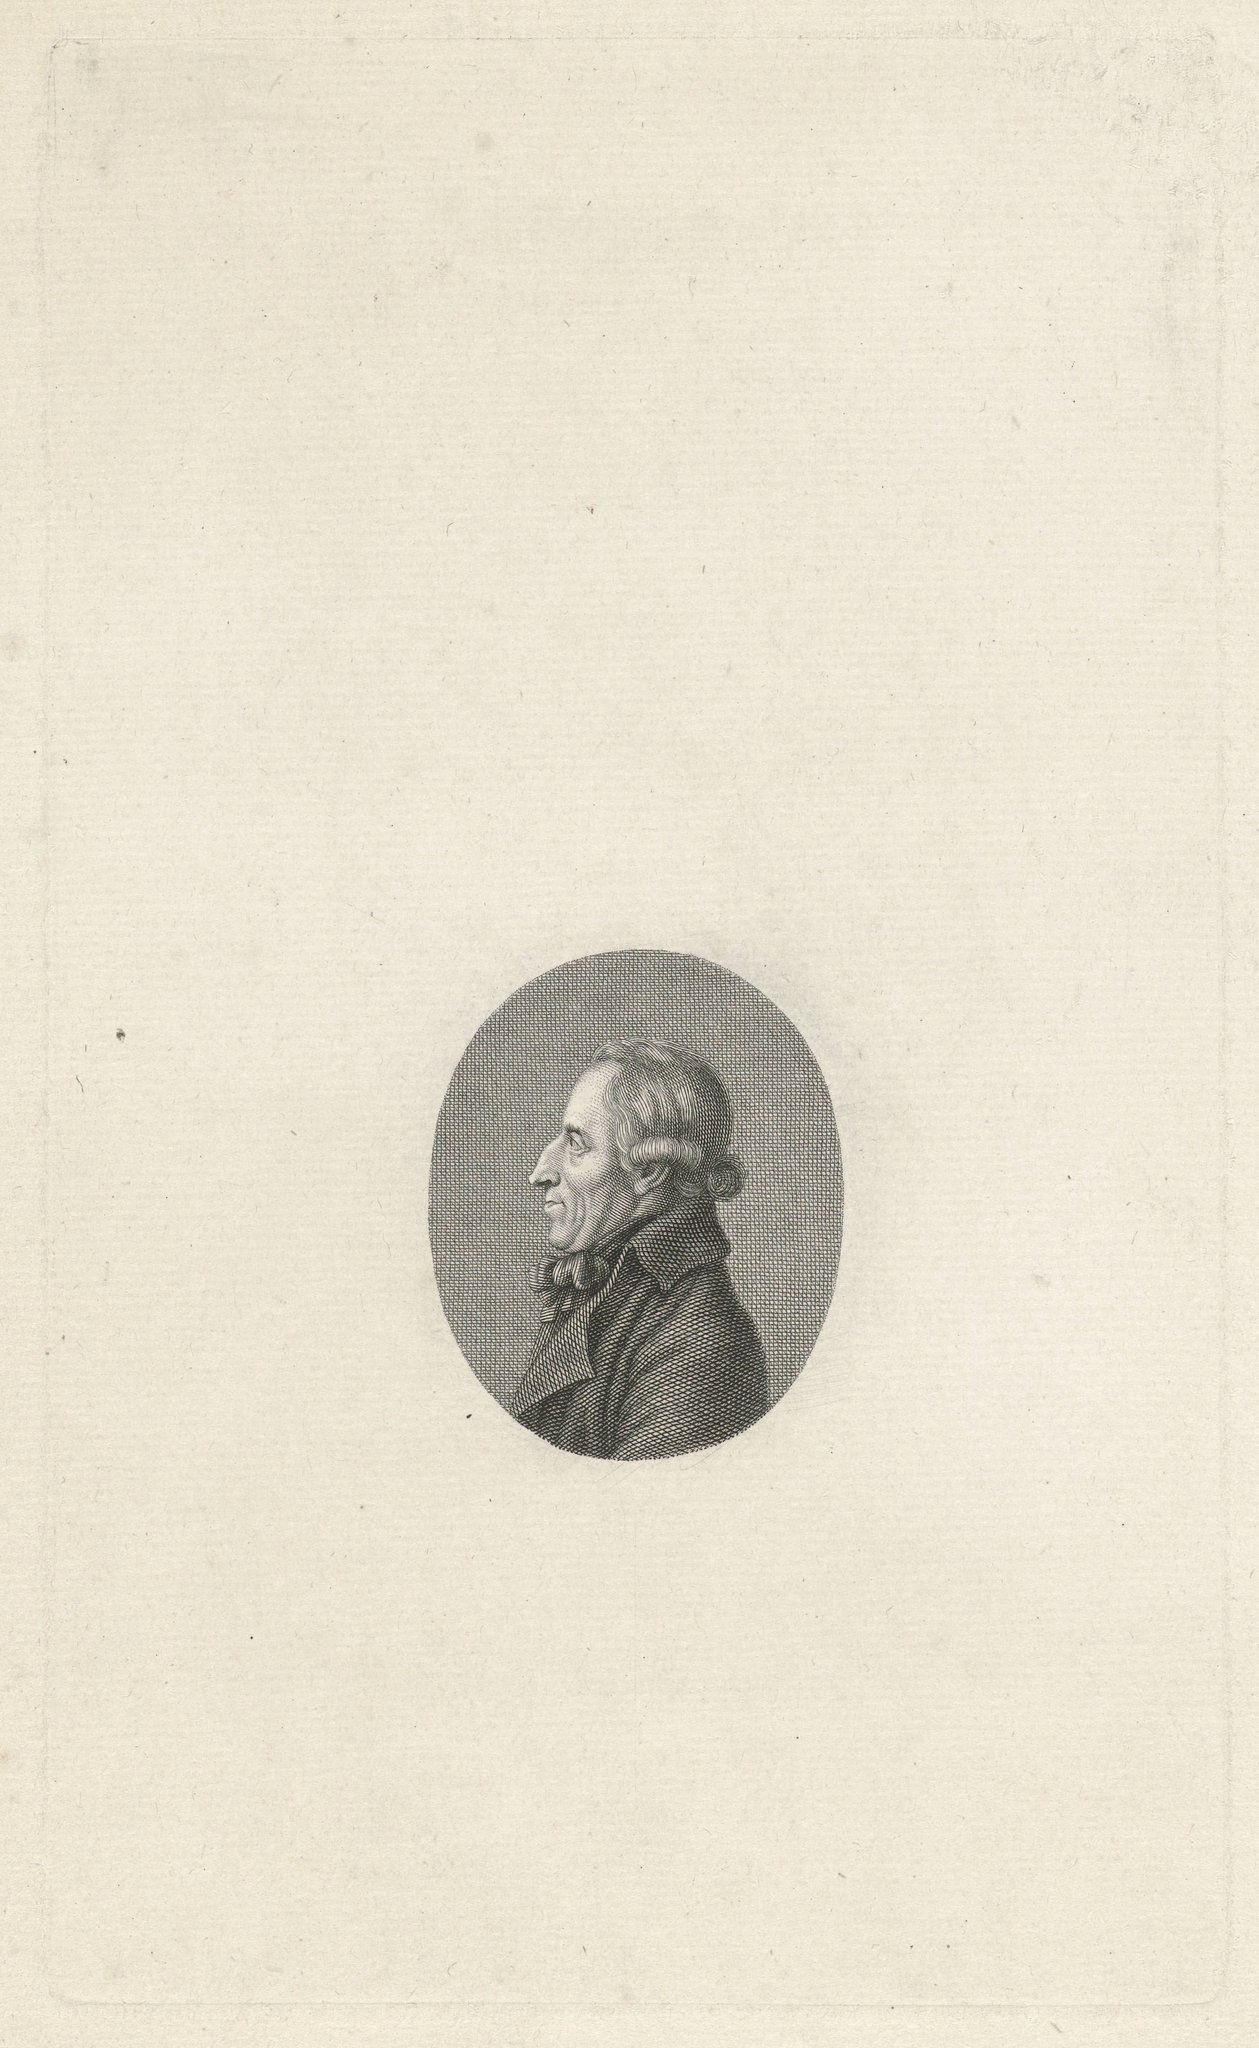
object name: print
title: Portret van Johann Jakob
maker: jacob ernst marcus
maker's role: draughtsman, print maker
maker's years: 1774-1826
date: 1818-1820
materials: paper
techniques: etching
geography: amsterdam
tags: zürich (stad), theoloog, johann jakob hess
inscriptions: name: ‘J.L. Ewald’, collector's mark: Lugt 2228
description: Buste van de Zwitserse theoloog Johann Jakob Hess.